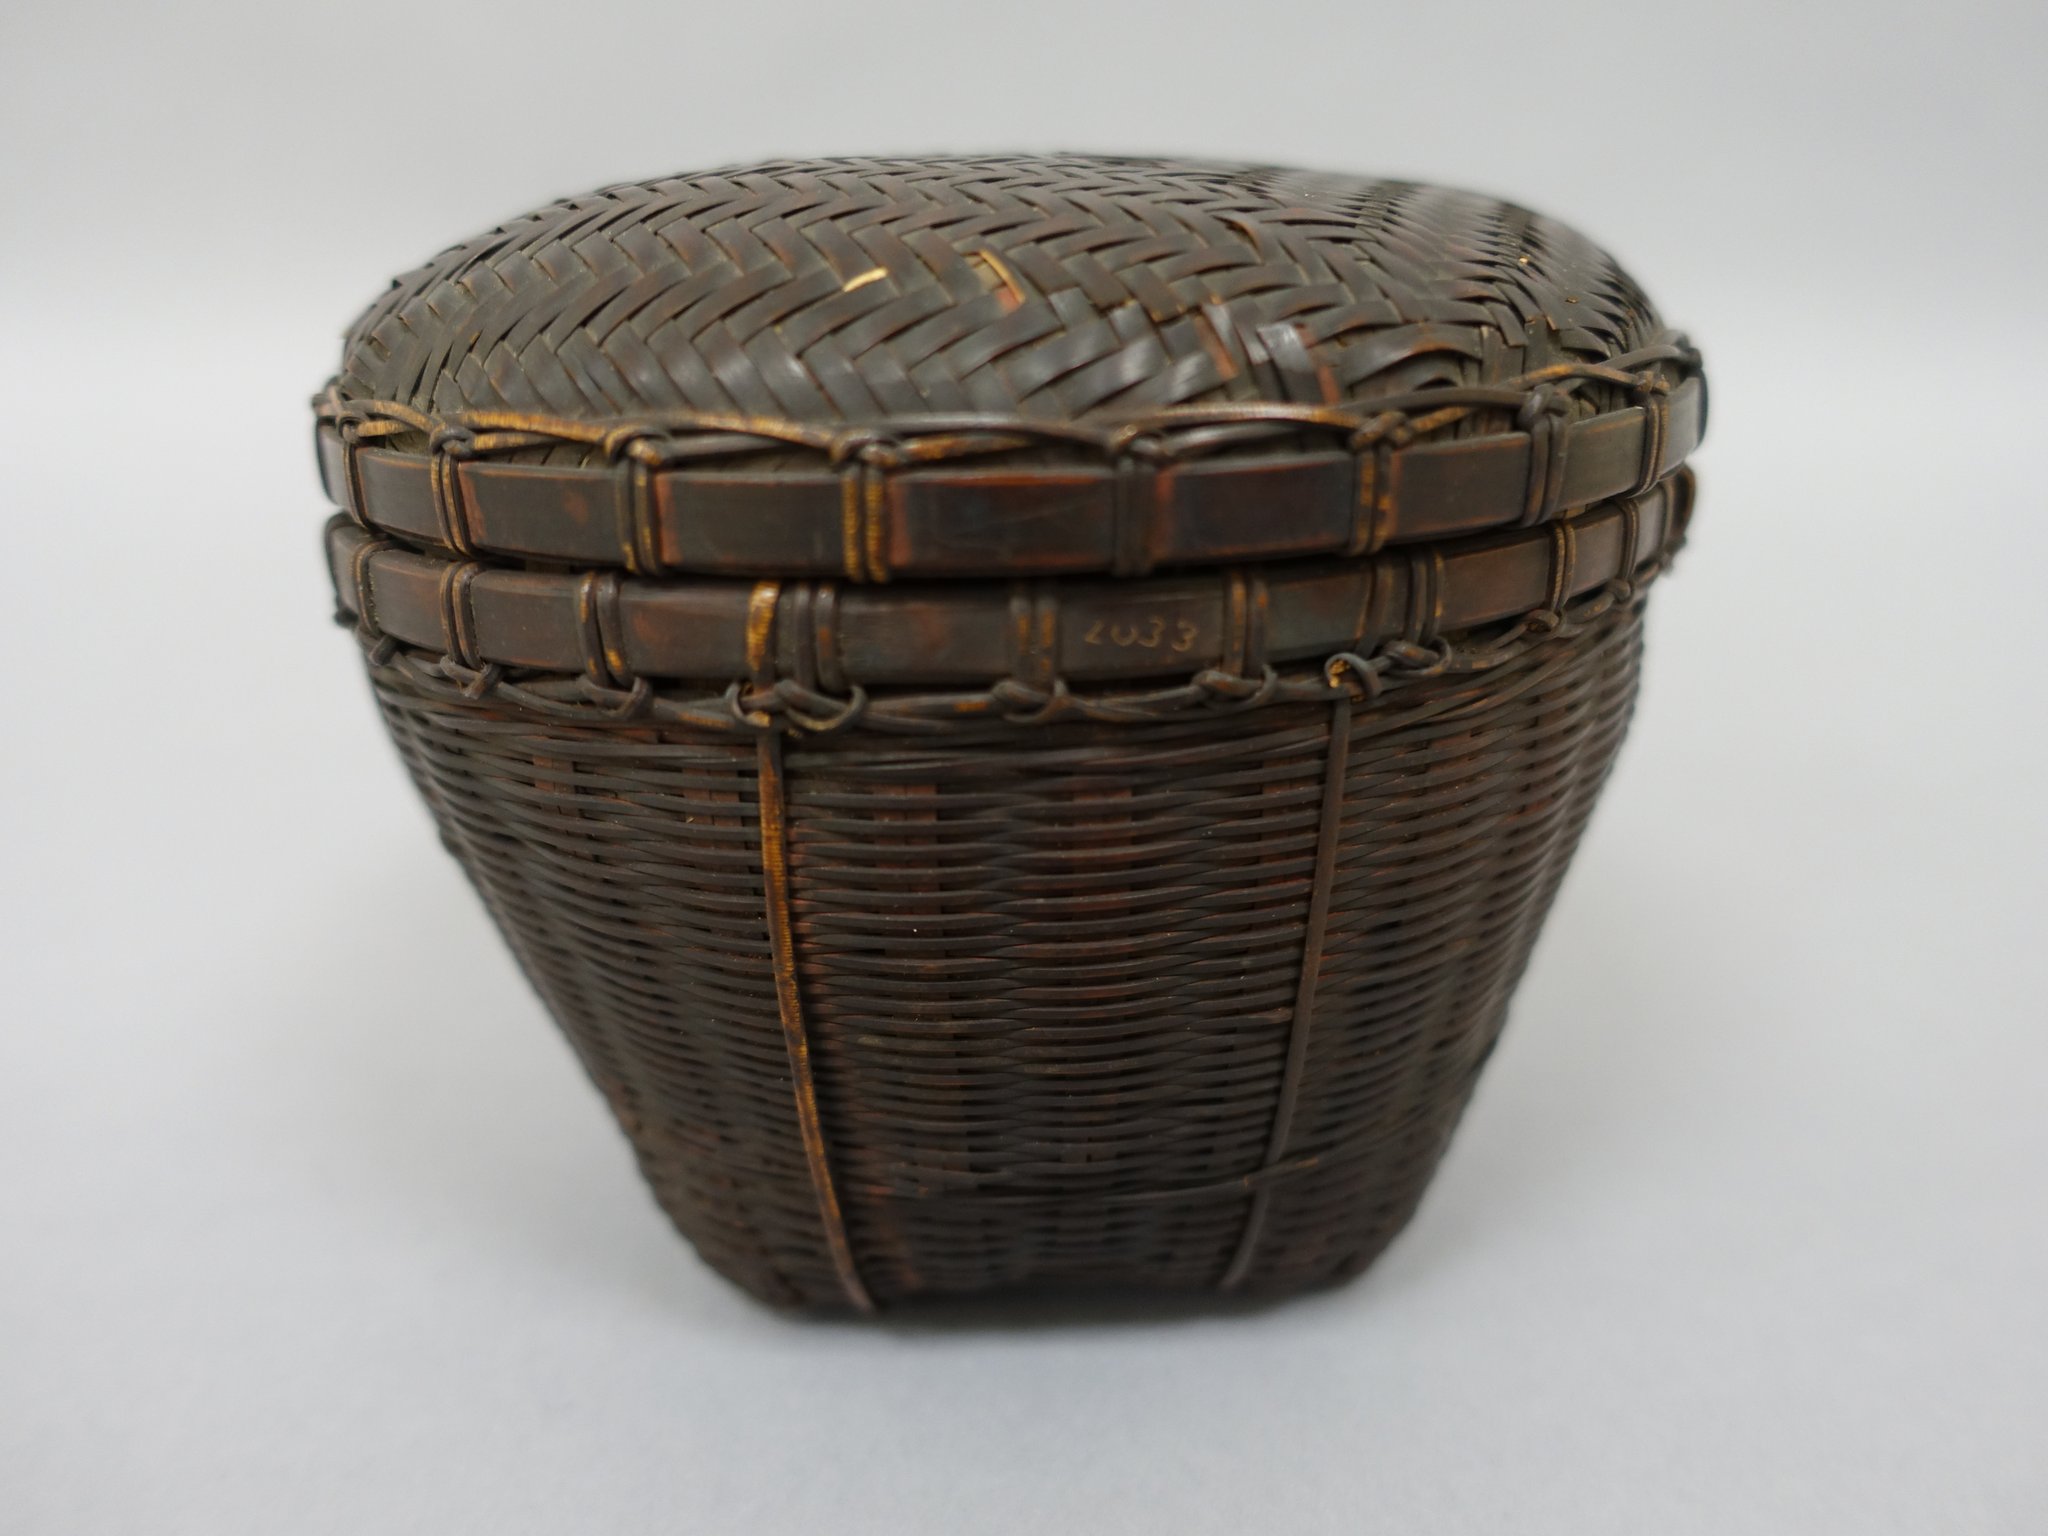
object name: covered basket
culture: japanese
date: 1801-1900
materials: rattan